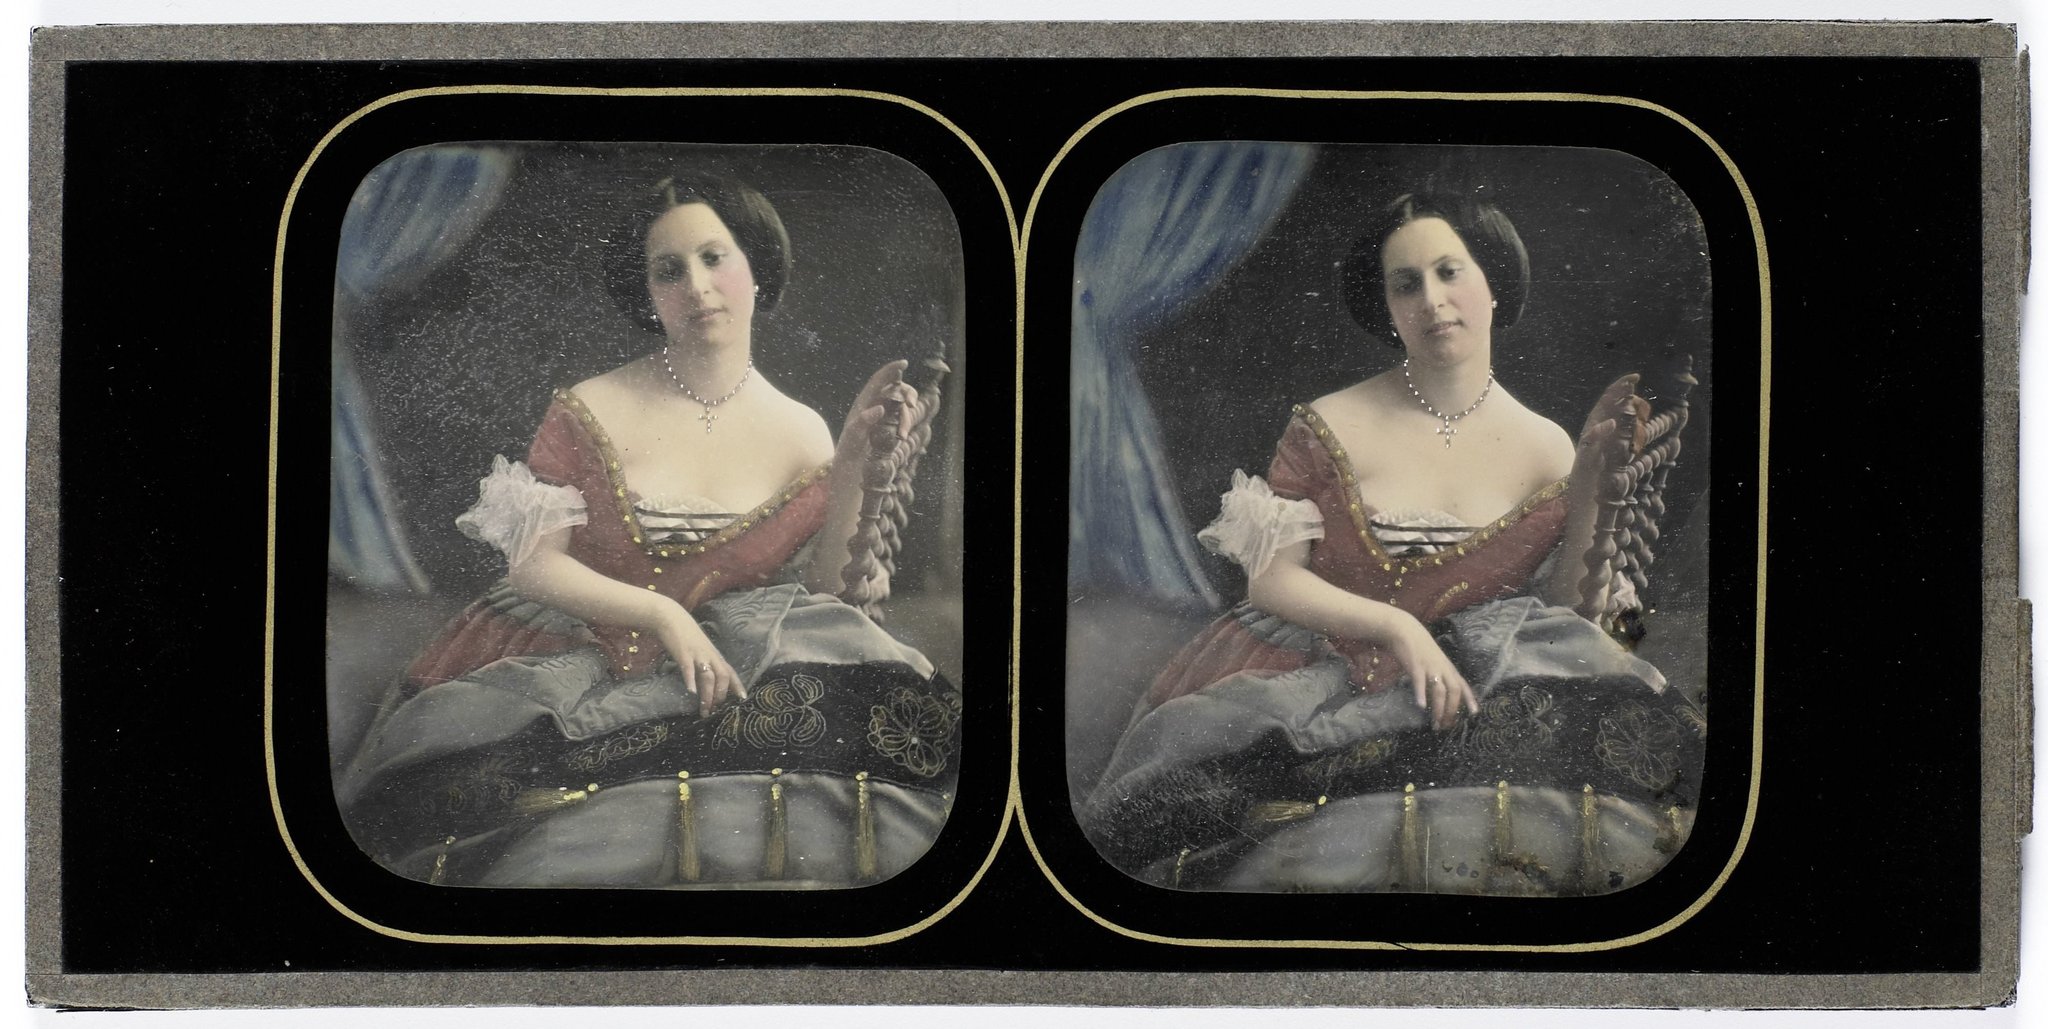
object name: stereograph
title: Portret van een onbekende vrouw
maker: Anonymous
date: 1851-1860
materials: copper, glass, paper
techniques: daguerreotype, hand coloring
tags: adult woman, anonymous historical person portrayed